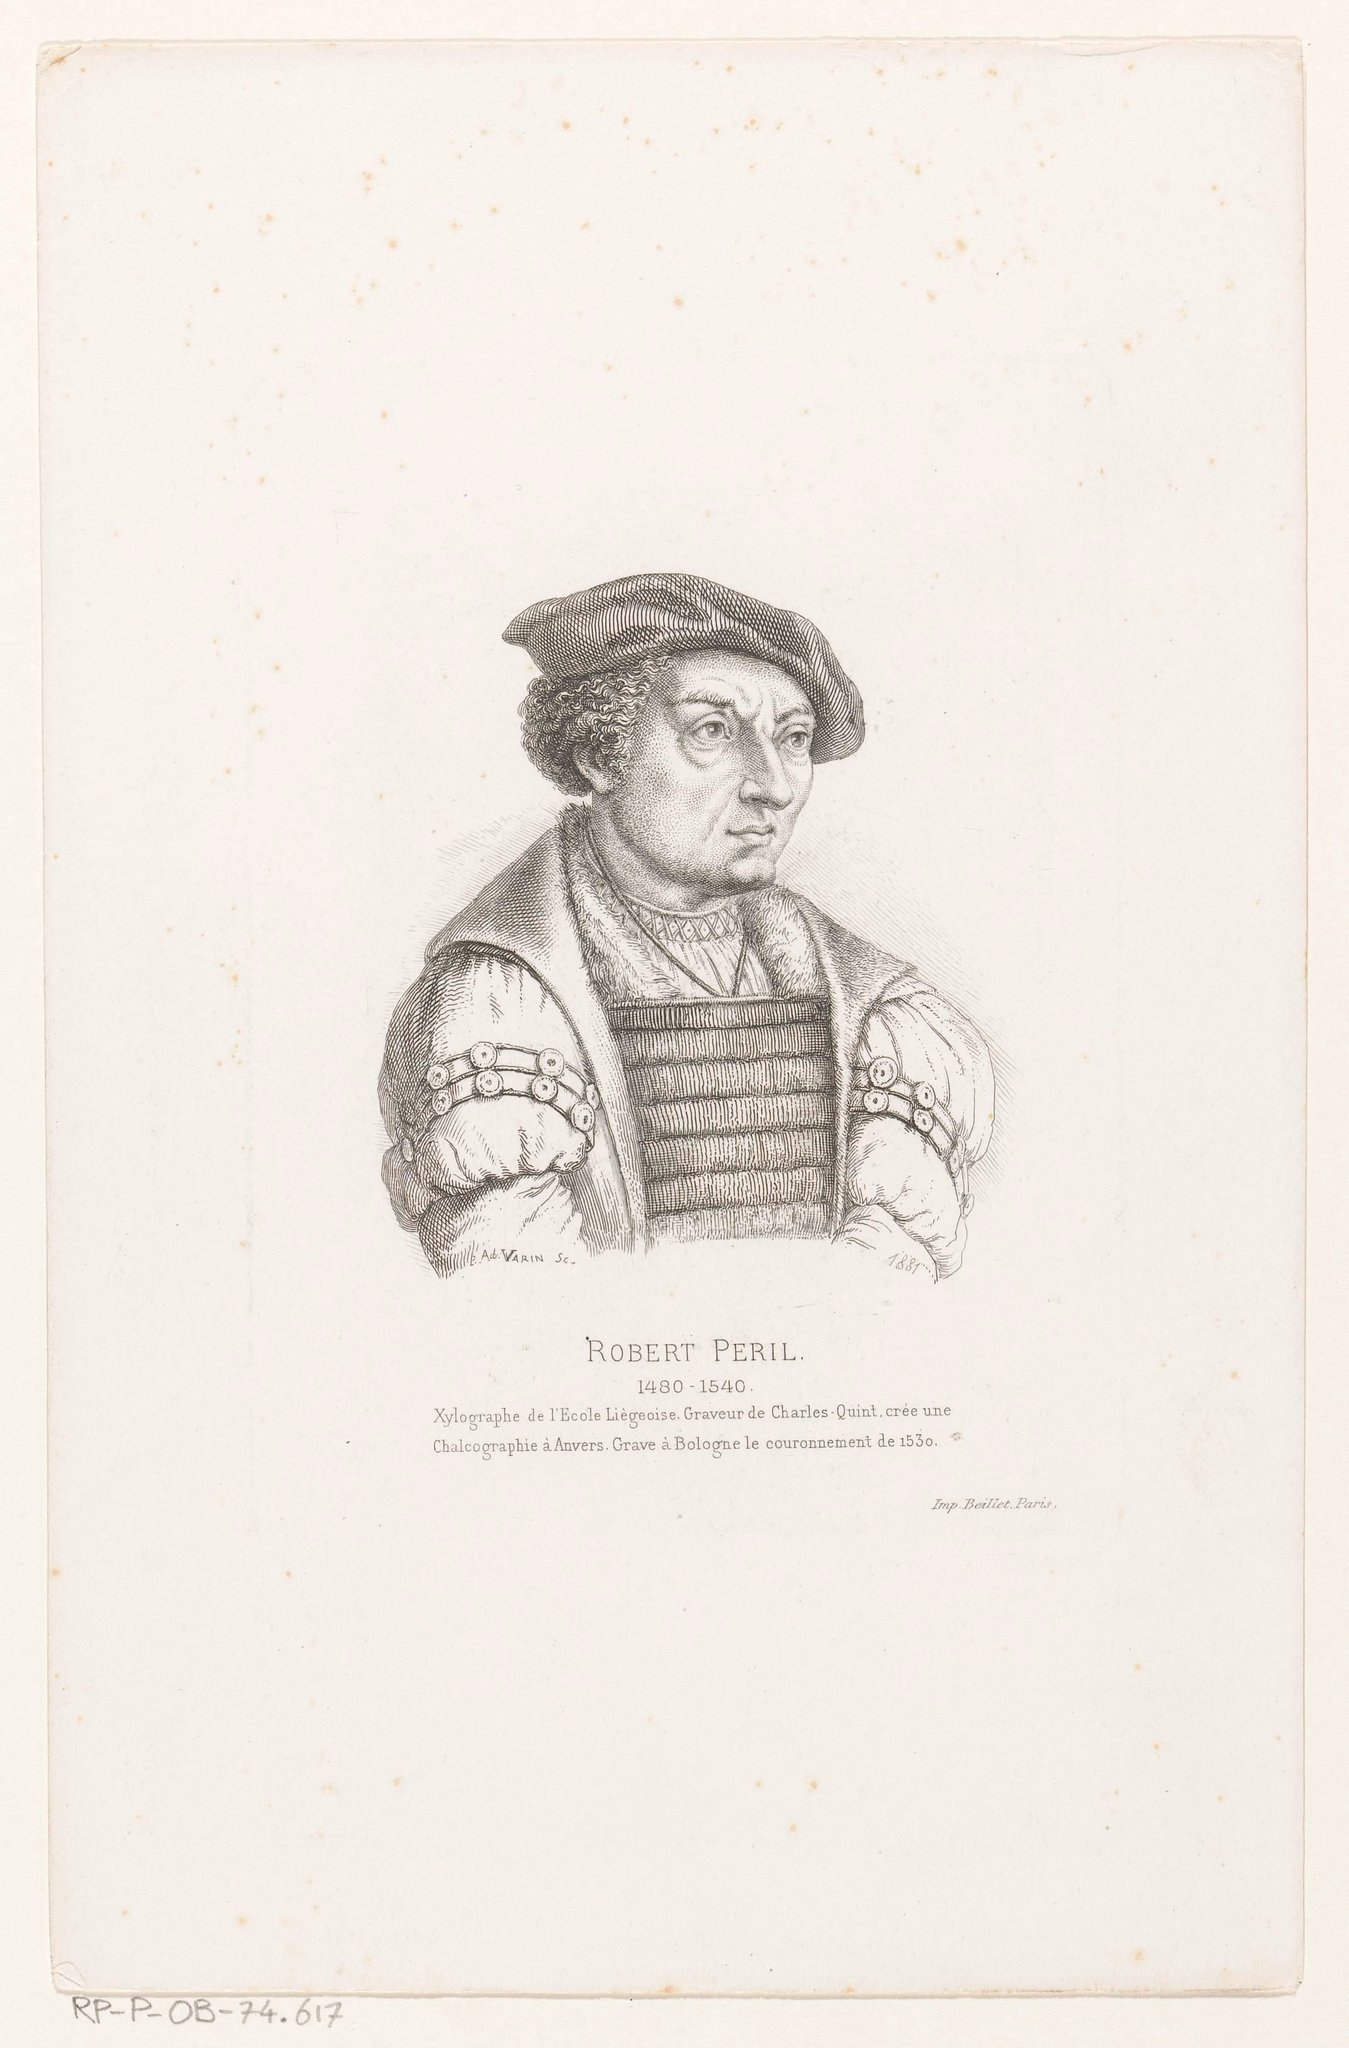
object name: print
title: Portret van Robert Péril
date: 1881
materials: paper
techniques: engraving, etching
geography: paris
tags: liège, print maker, draughtsman, robert péril, historical persons, portrait, self-portrait of artist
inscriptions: collector's mark: Lugt 2228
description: Prent uit: École liégeoise. Les Graveurs. Leurs portraits, reproduits au burin, d'après les originaux, par Adolphe Varin, 1366-1850. Avec notes historiques (...). Parijs: Fr. Gobbaerts, ca. 1684.